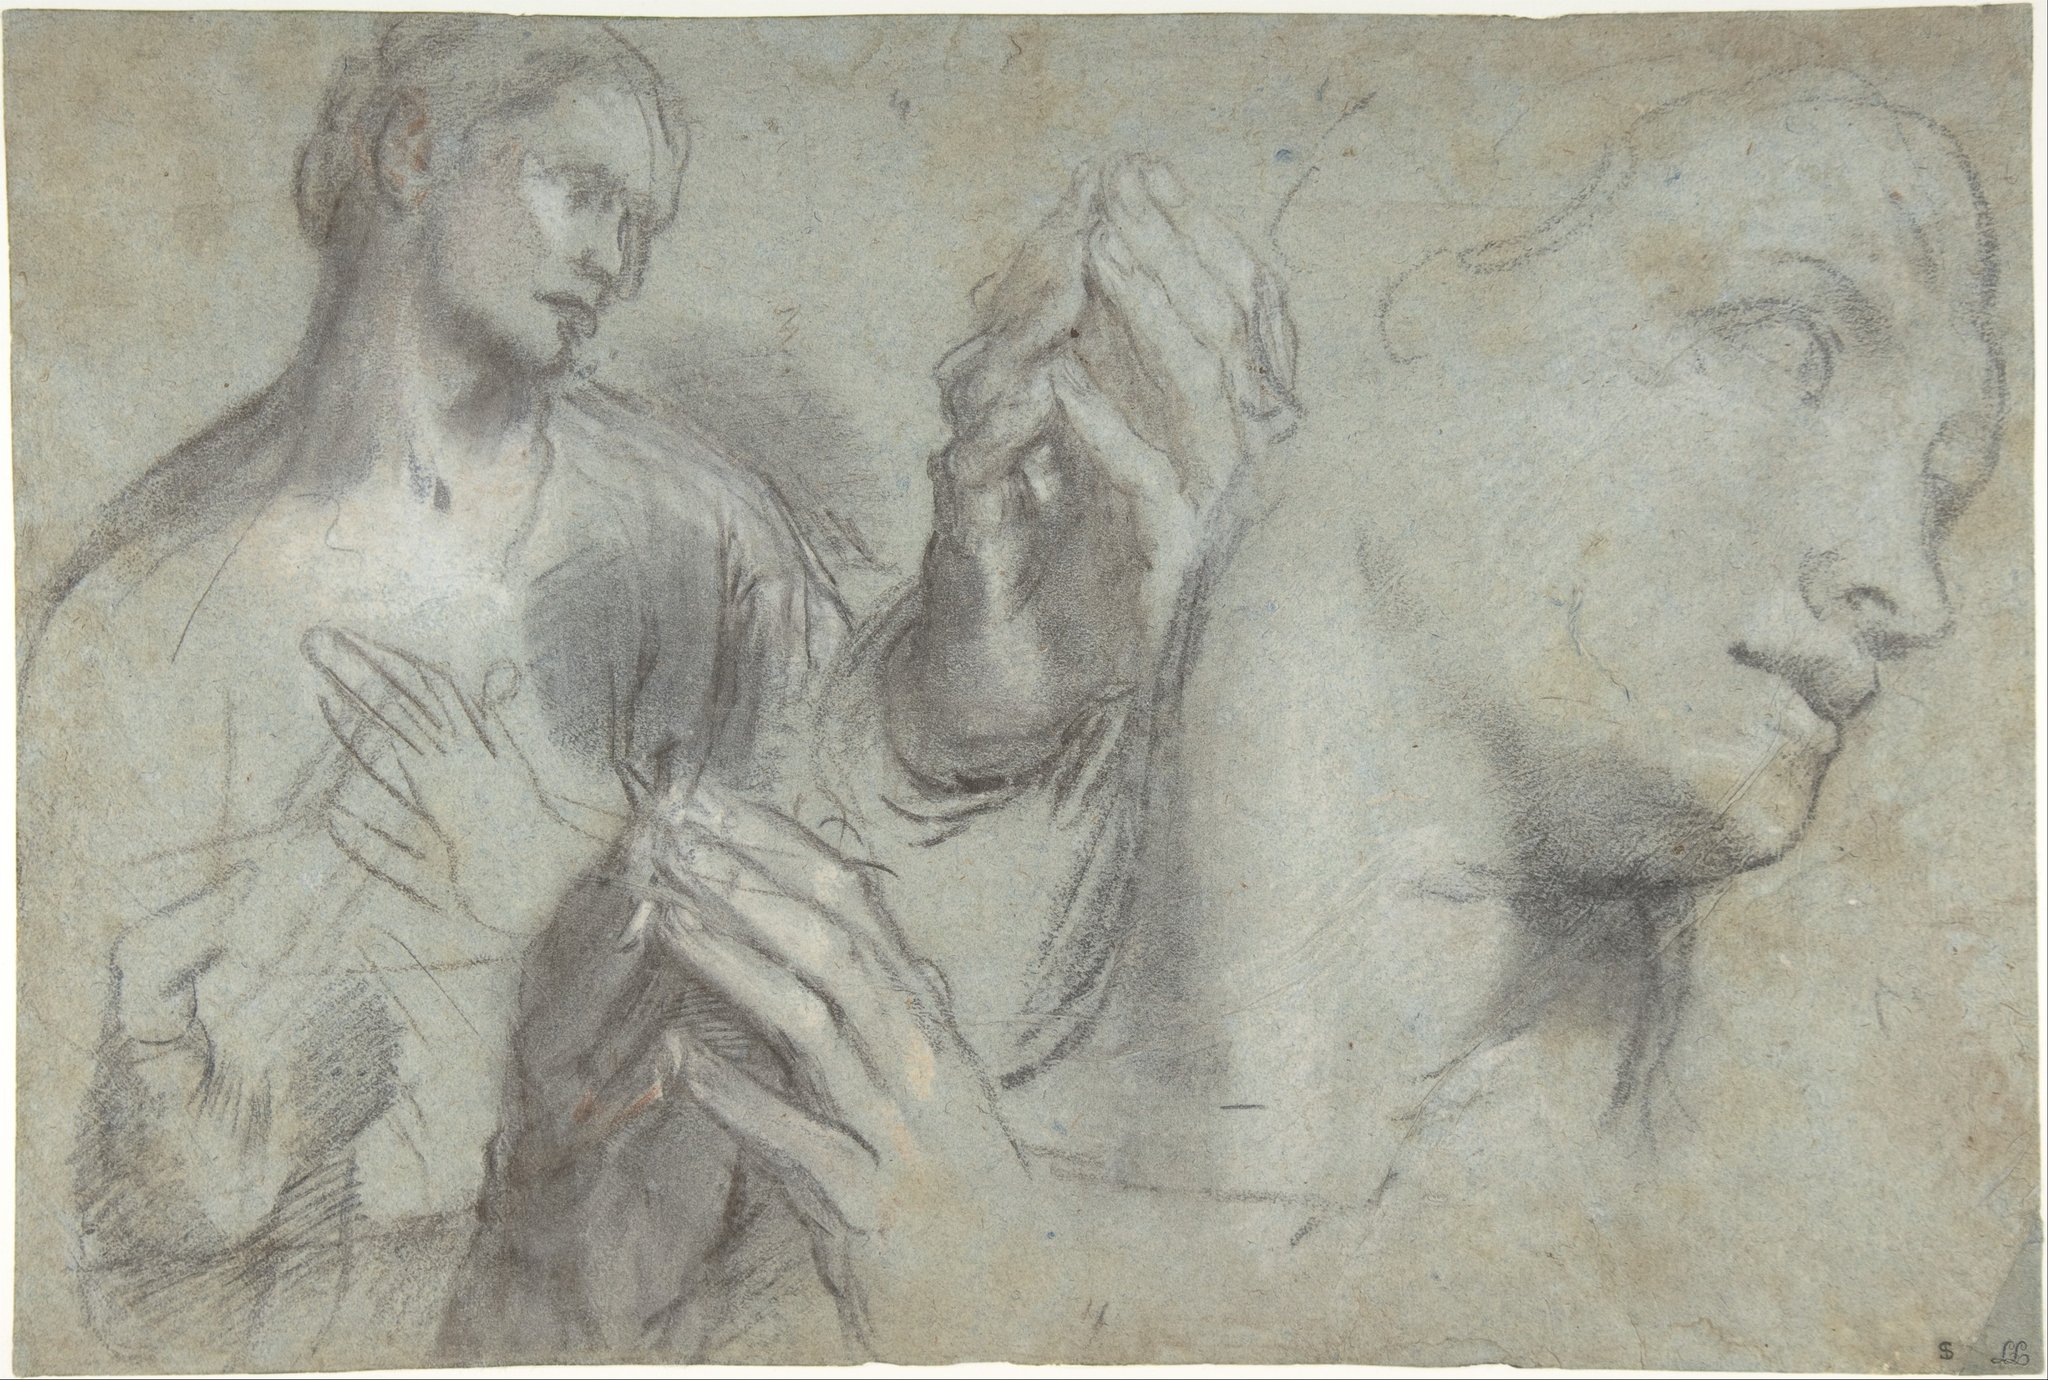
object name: drawing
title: Studies of a Man's Head and of His Hands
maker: federico barocci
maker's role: artist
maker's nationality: italian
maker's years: 1535-1612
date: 1592-1599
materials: chalk, paper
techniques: highlighting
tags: hands,heads,men